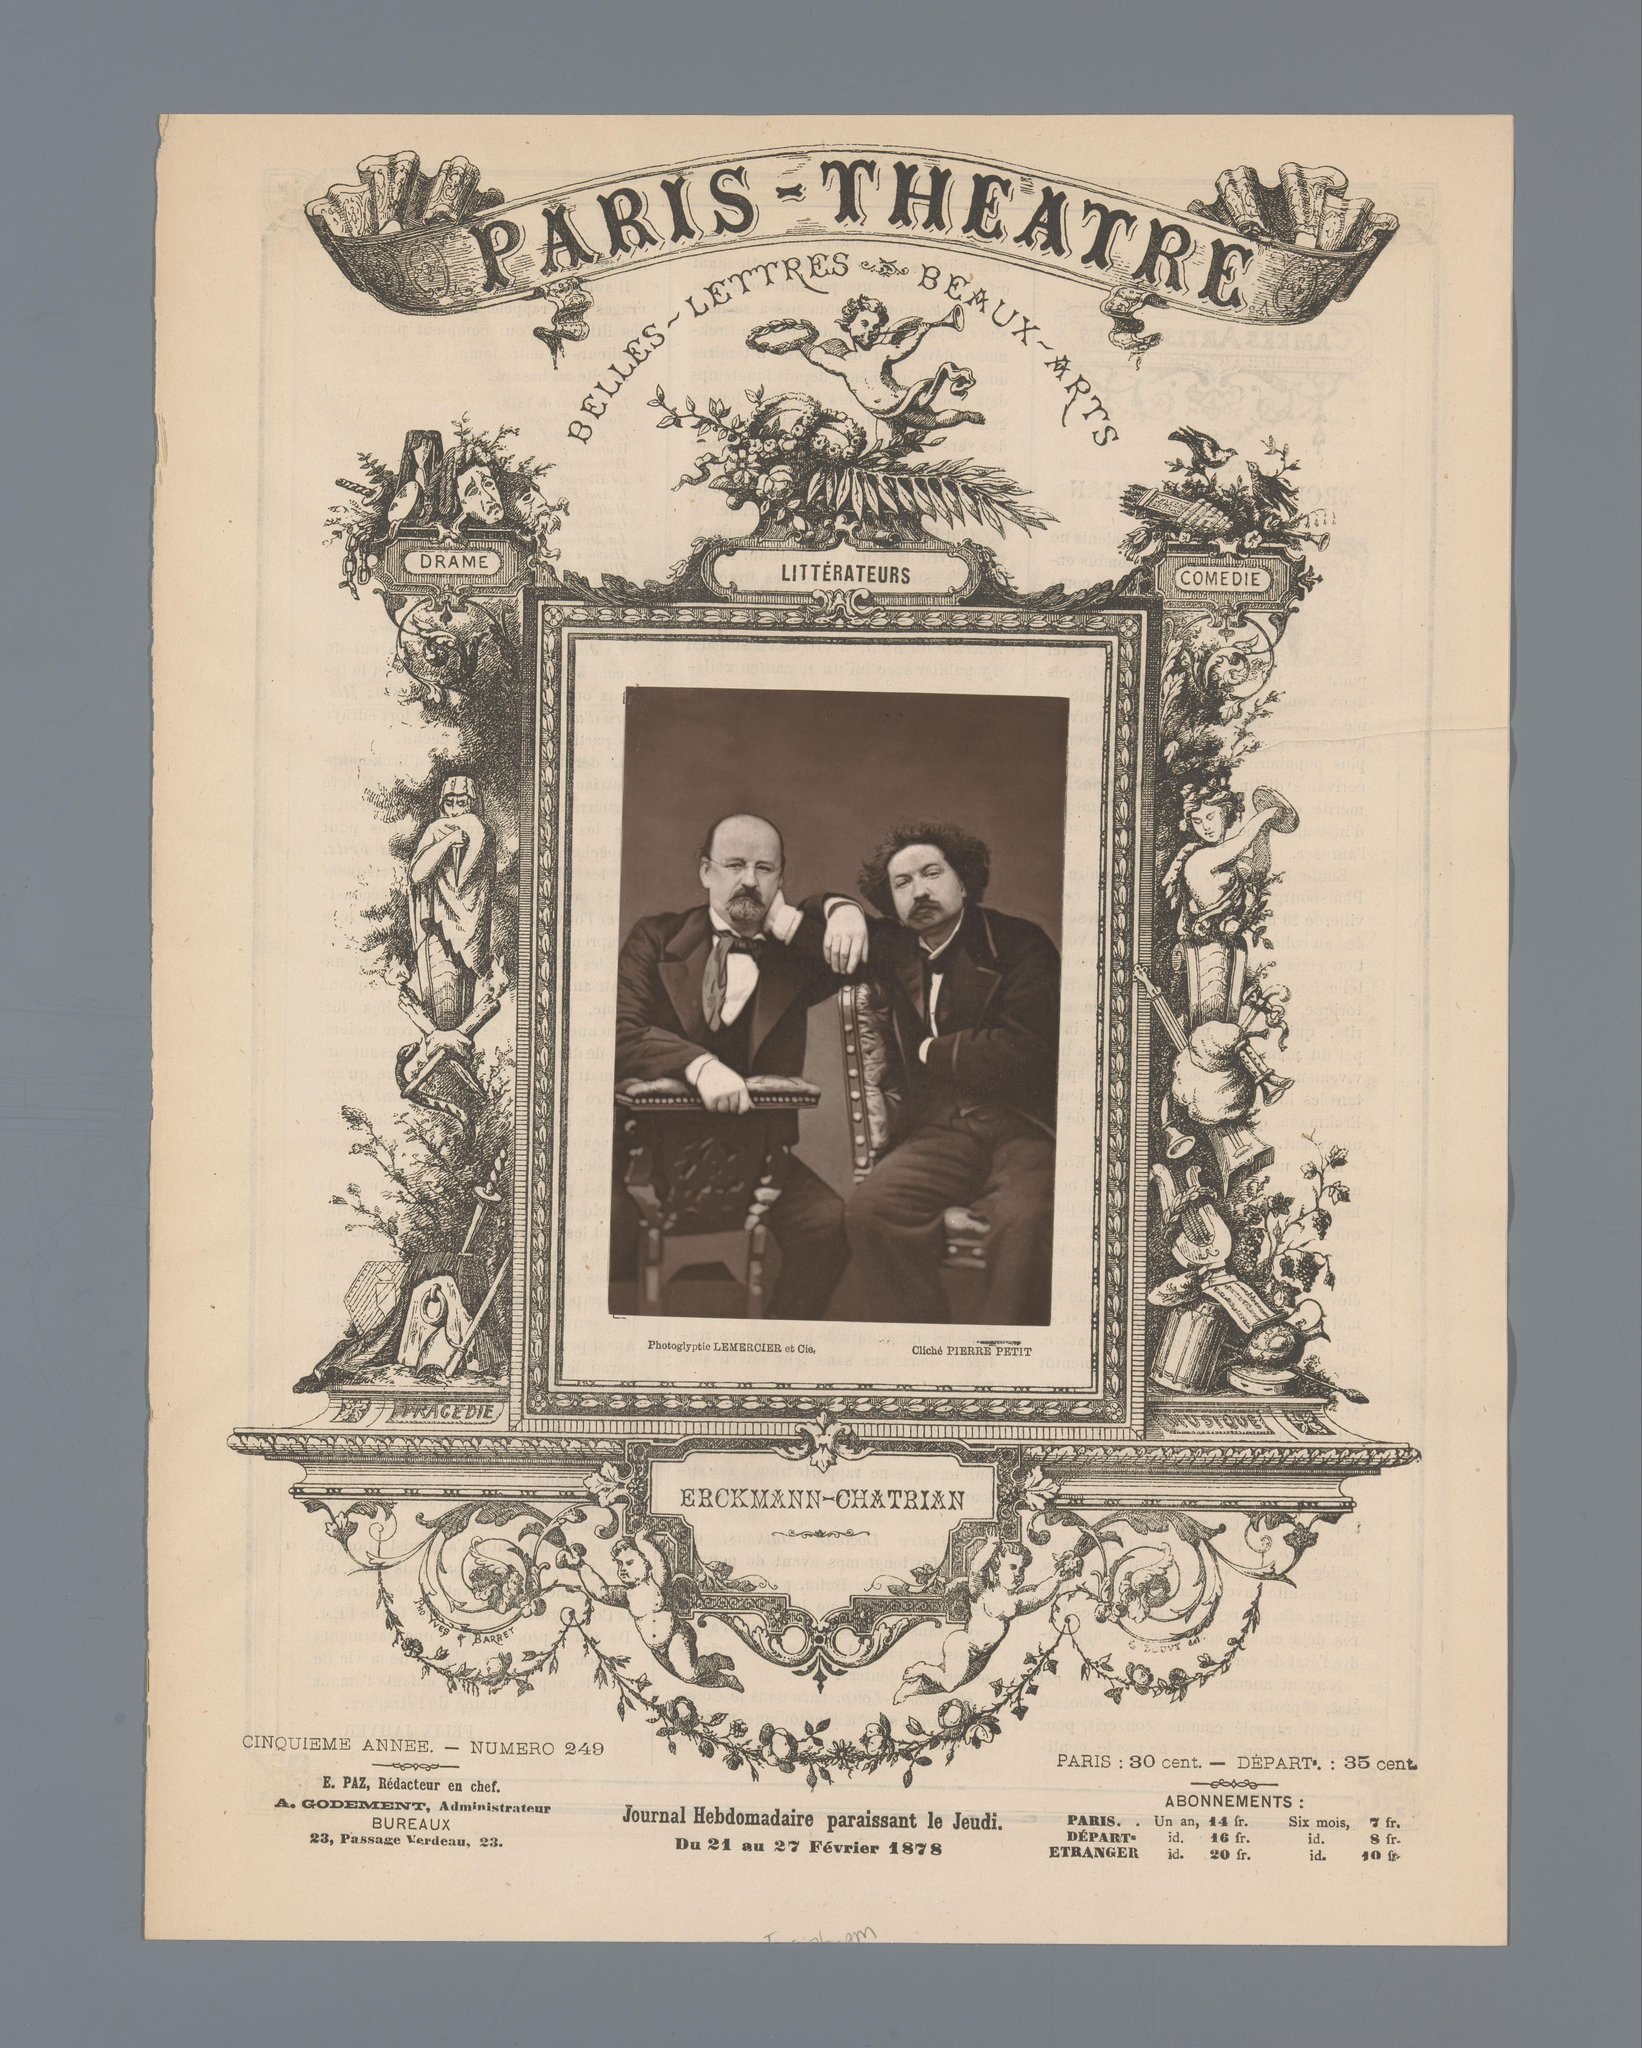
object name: photomechanical print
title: Portret van Émile Erckmann en Alexandre Chatrian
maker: pierre petit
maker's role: fotograaf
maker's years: 1832-1909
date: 1872-1879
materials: paper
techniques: woodburytype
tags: historical persons